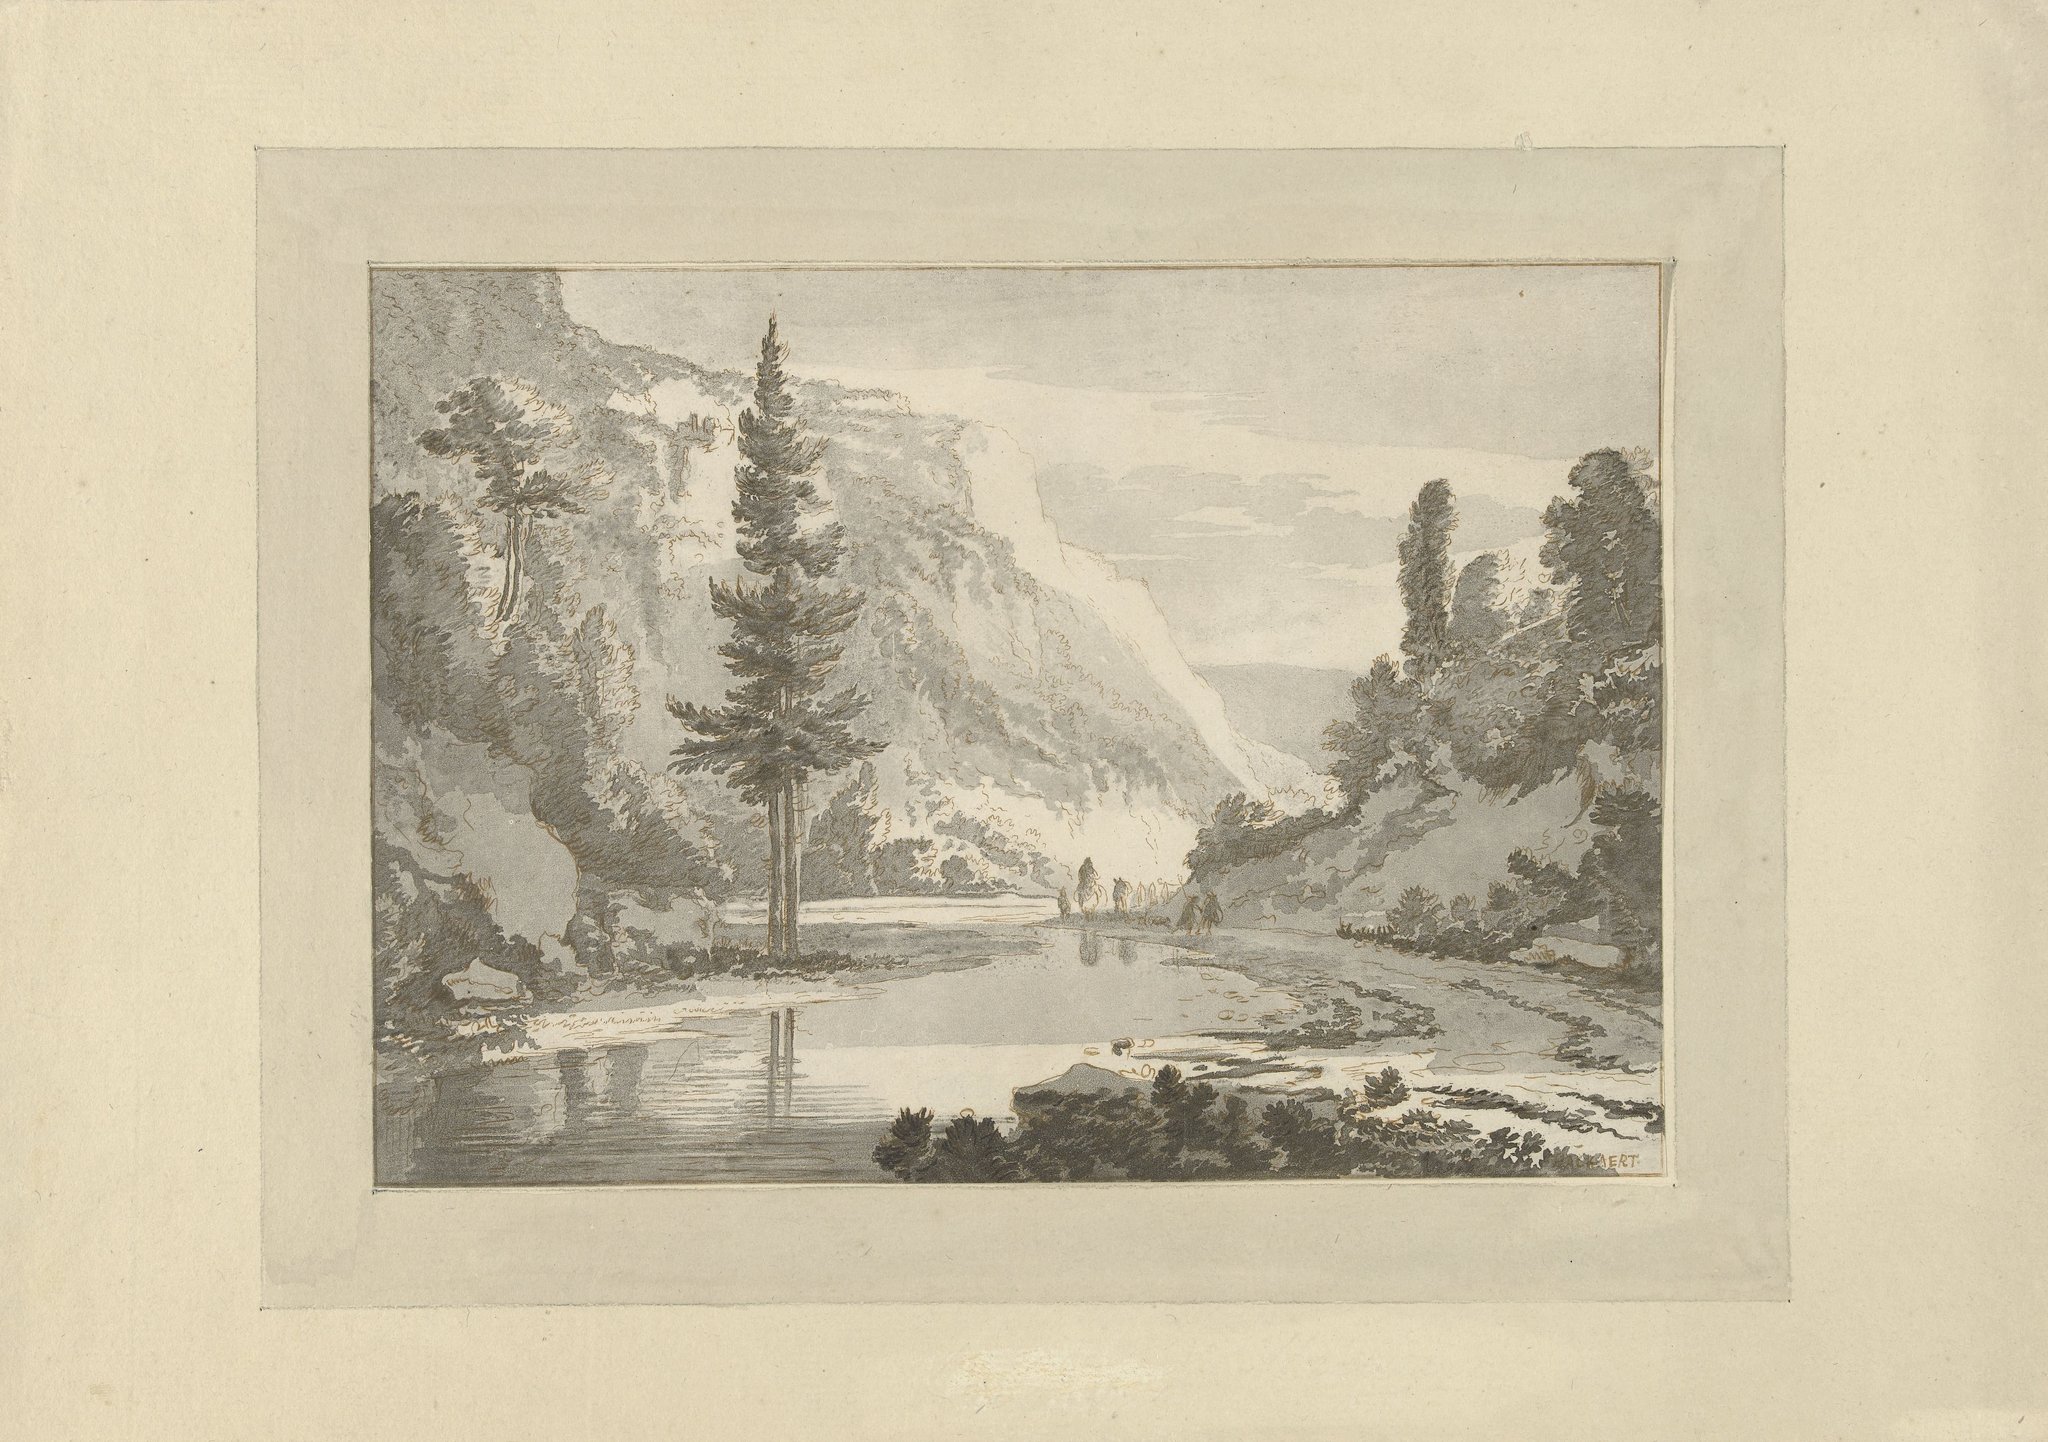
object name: print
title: Berglandschap met herders op een rivieroever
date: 1821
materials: paper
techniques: aquatint, etching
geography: amsterdam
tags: landscapes - hh - ideal landscapes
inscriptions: collector's mark: Lugt 2228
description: Door Christiaan Josi opgenomen in een uitgave met 100 werken naar Hollandse en Vlaamse meesters: Collection d'imitations de dessins d'après les principaux maîtres hollandais et flamands, Londen, C.Josi, 1821. Alle prenten in deze uitgave dragen op het verso het wapen van Cornelis Ploos van Amstel, de initiatiefnemer voor de uitgave.